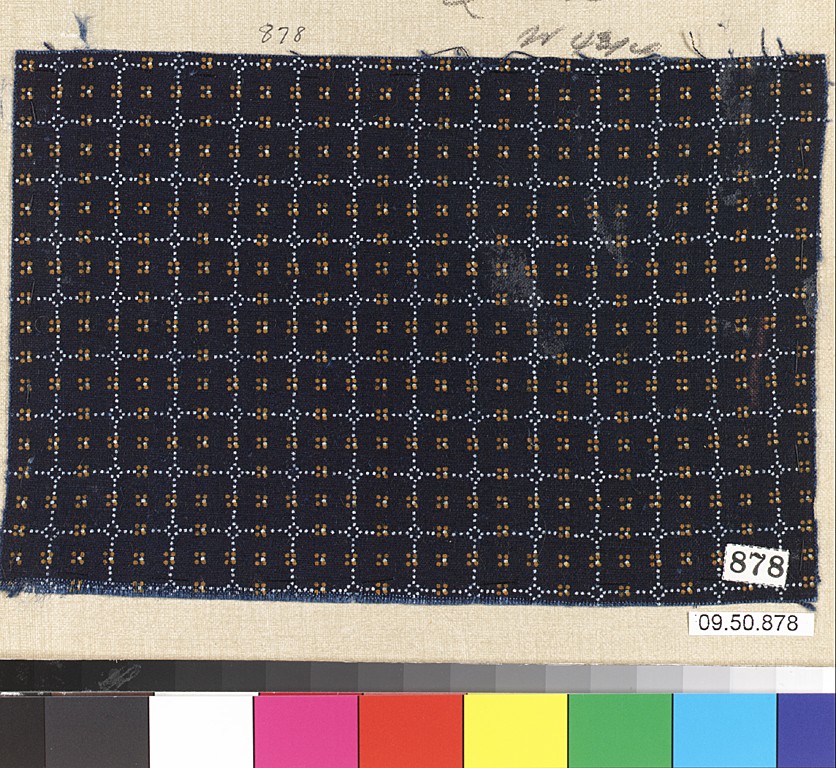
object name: piece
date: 1801-1900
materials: cotton